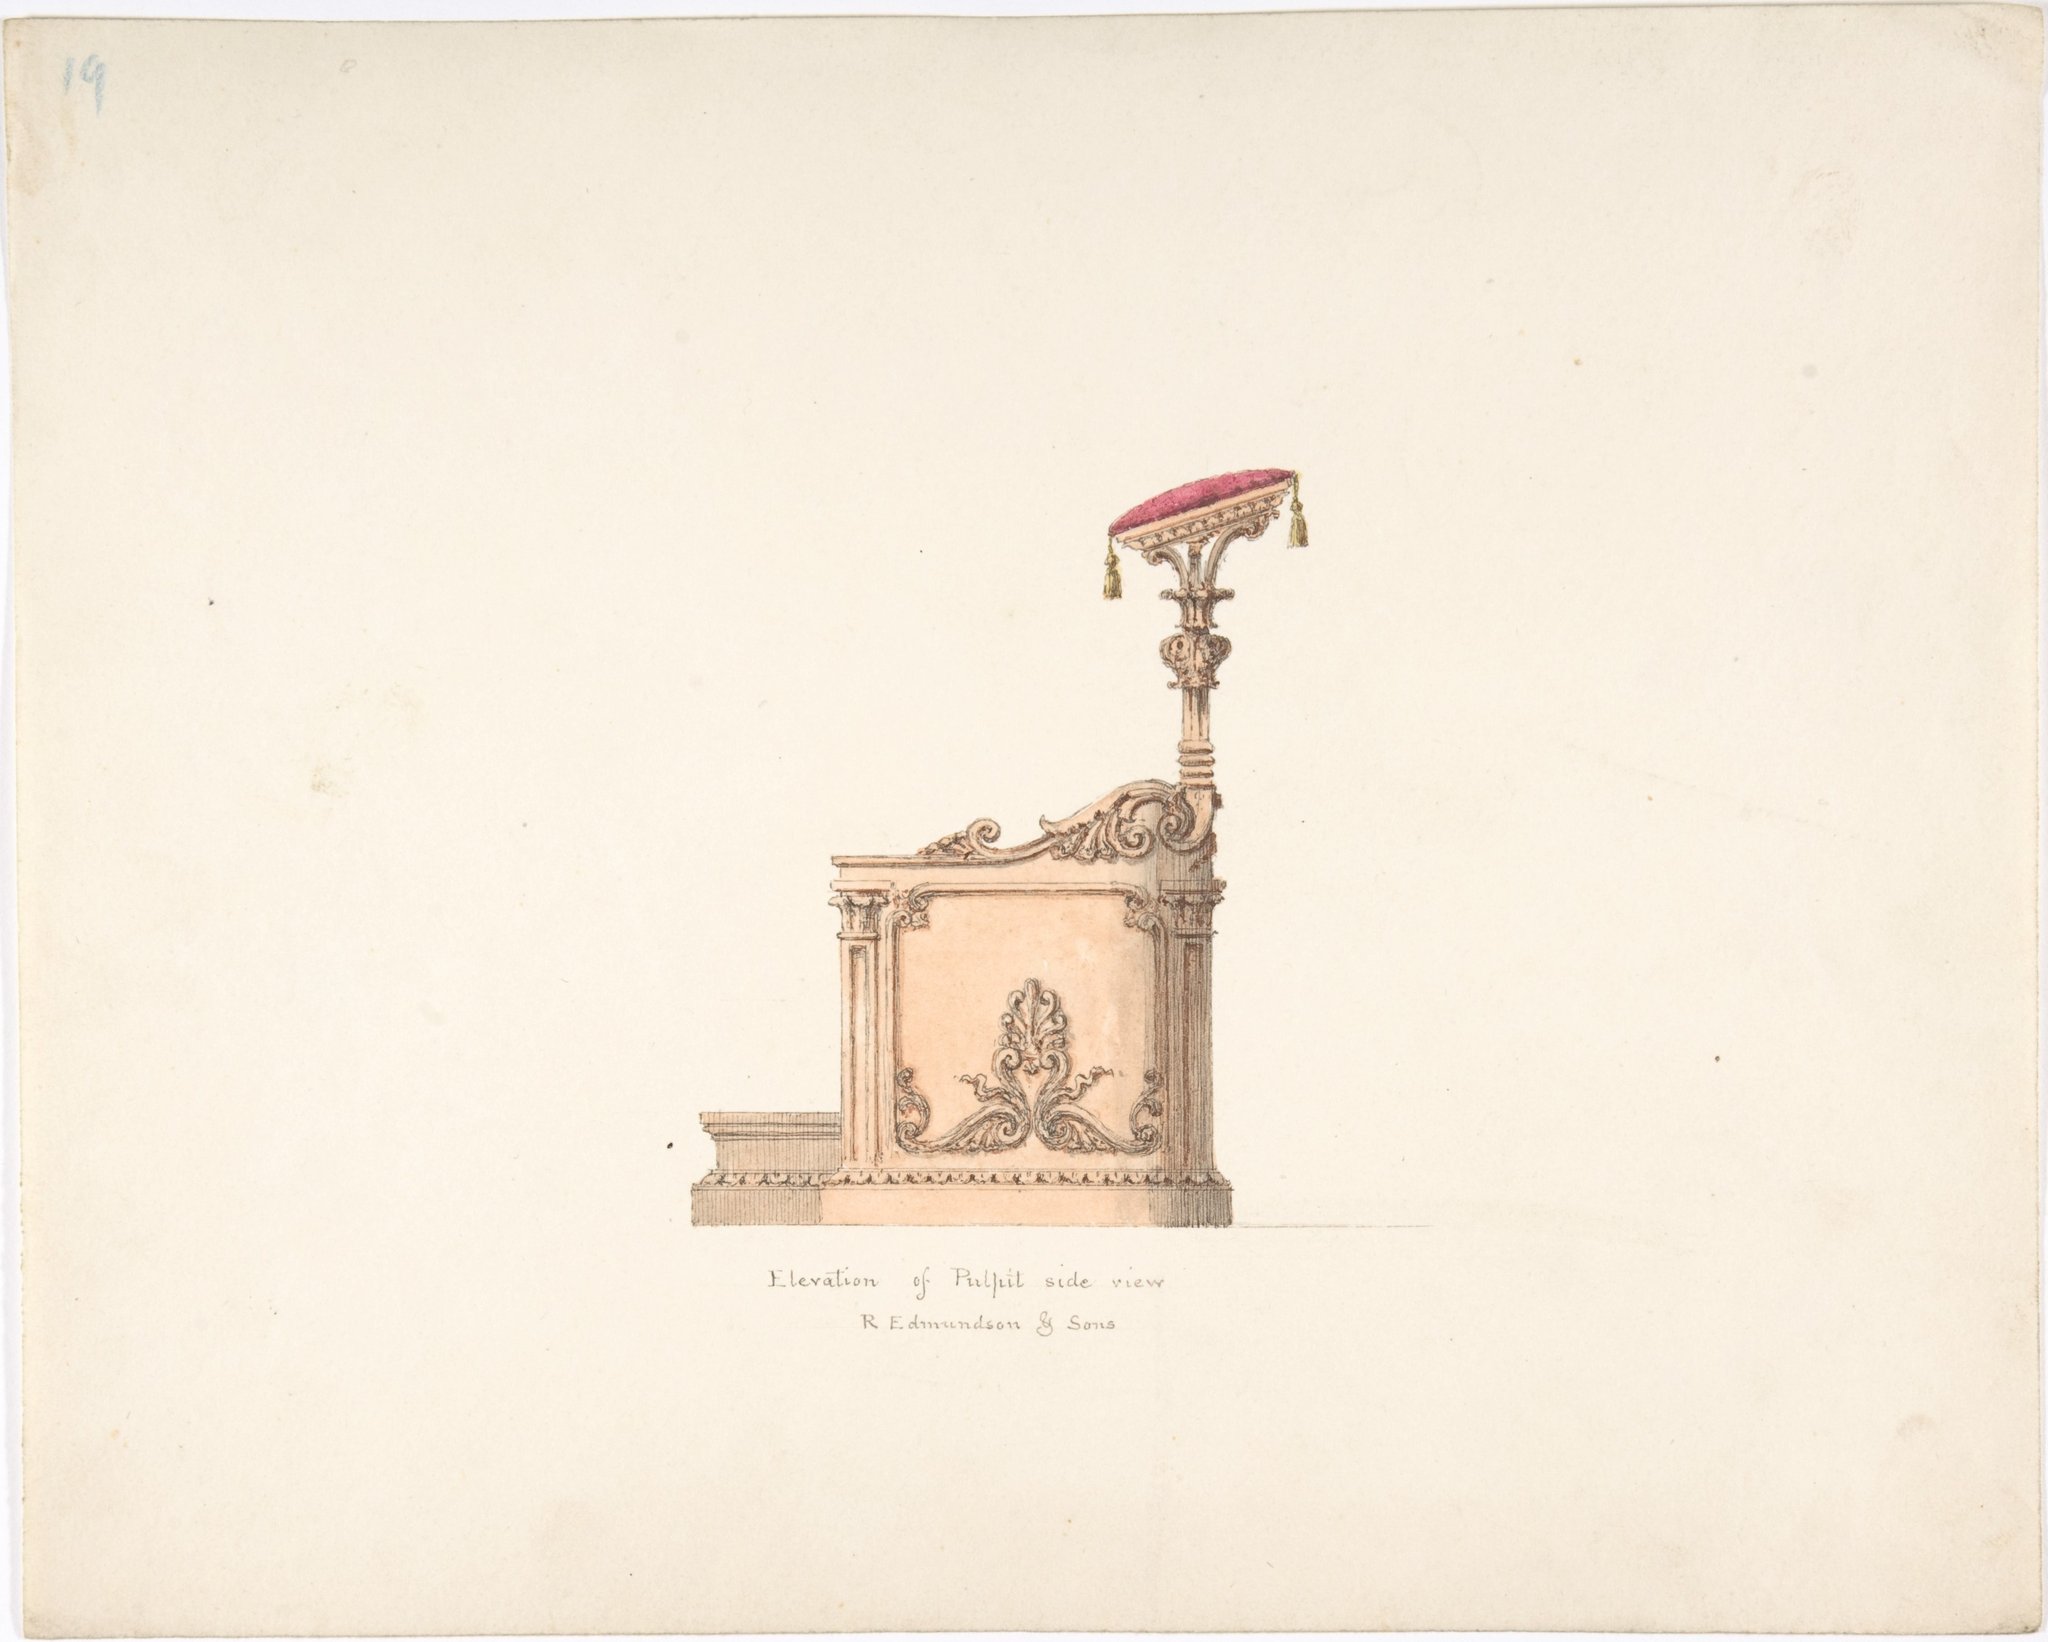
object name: drawing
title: Elevation of a Pulpit, Side View, R. Edmundson & Sons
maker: anonymous, british, 19th century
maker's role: artist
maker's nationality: british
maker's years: 1800-1900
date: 1801-1833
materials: ink, watercolor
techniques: pen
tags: ornament